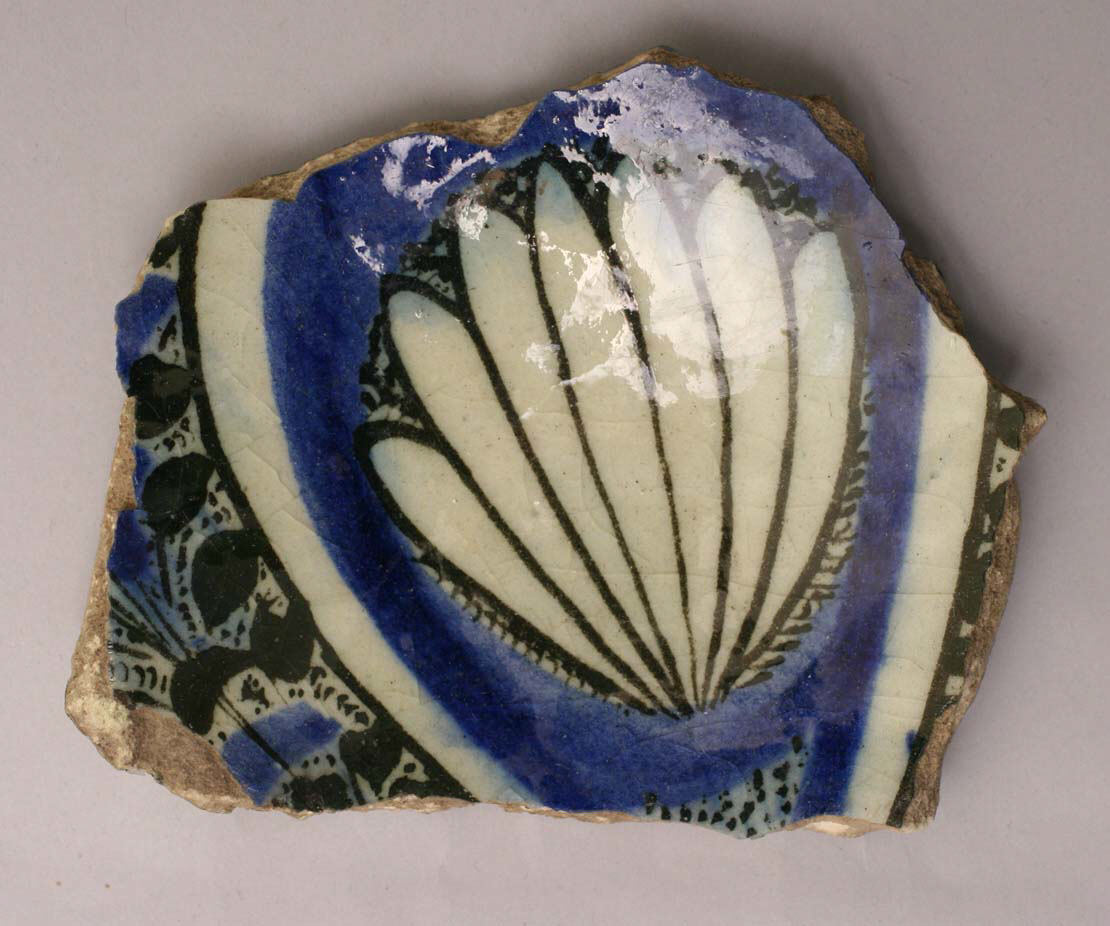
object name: fragment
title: Ceramic Fragment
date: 1301-1400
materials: glaze, stonepaste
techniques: painting, polychrome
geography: syria